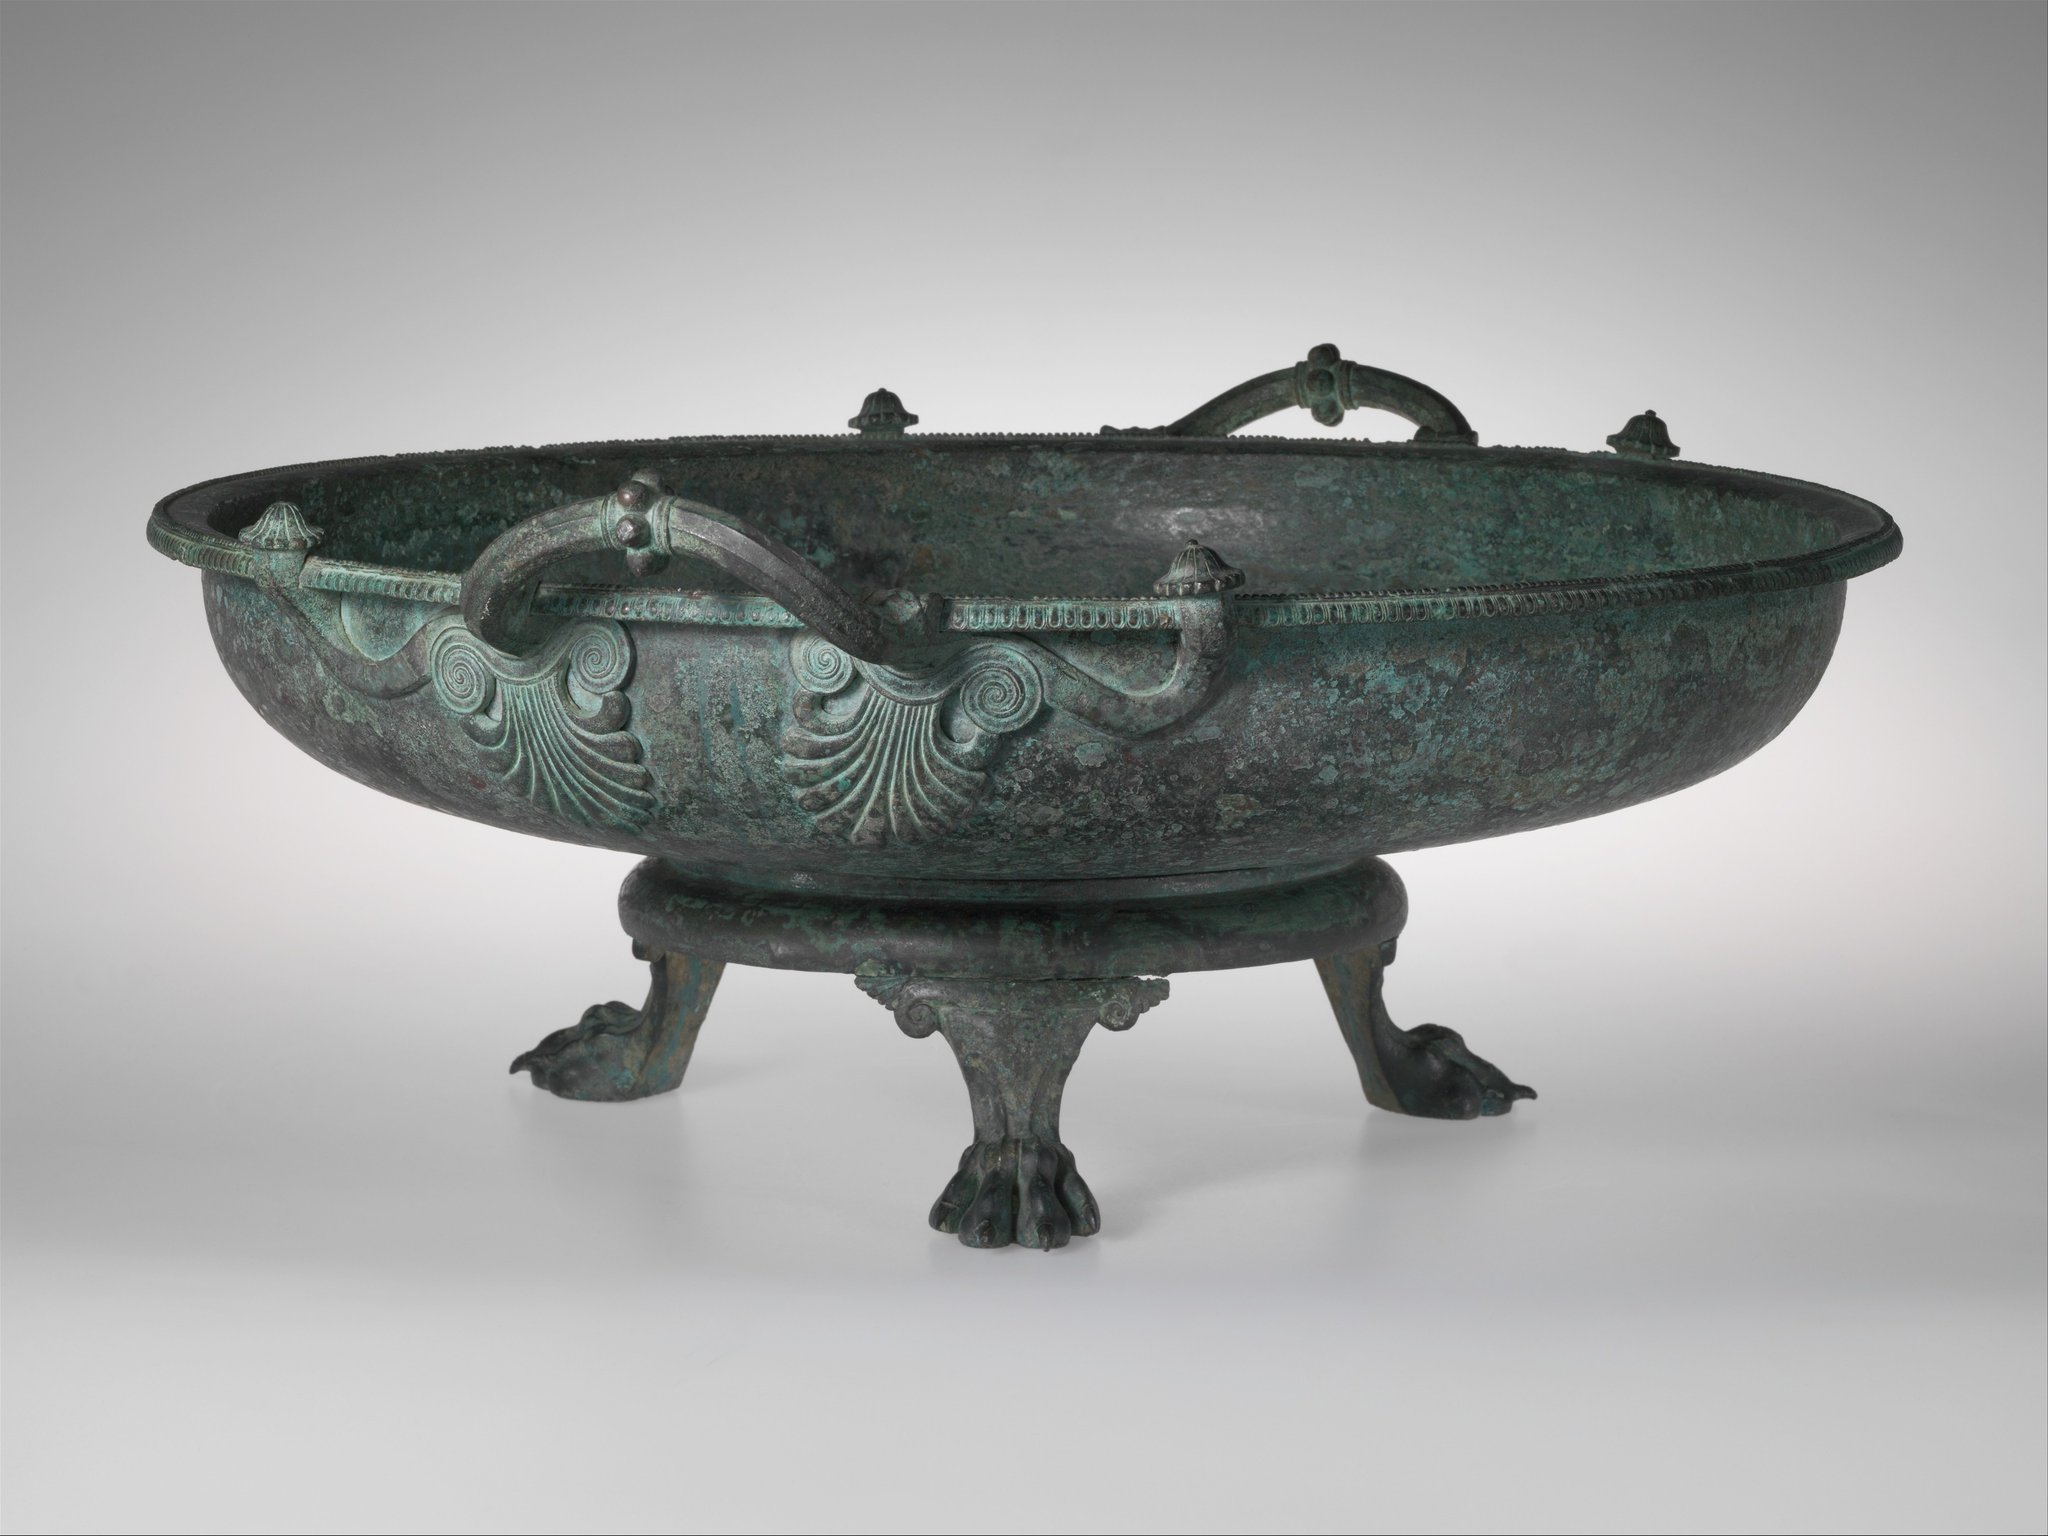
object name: footbath with three paw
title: Bronze footbath with its stand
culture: greek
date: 434-368 BCE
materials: bronze